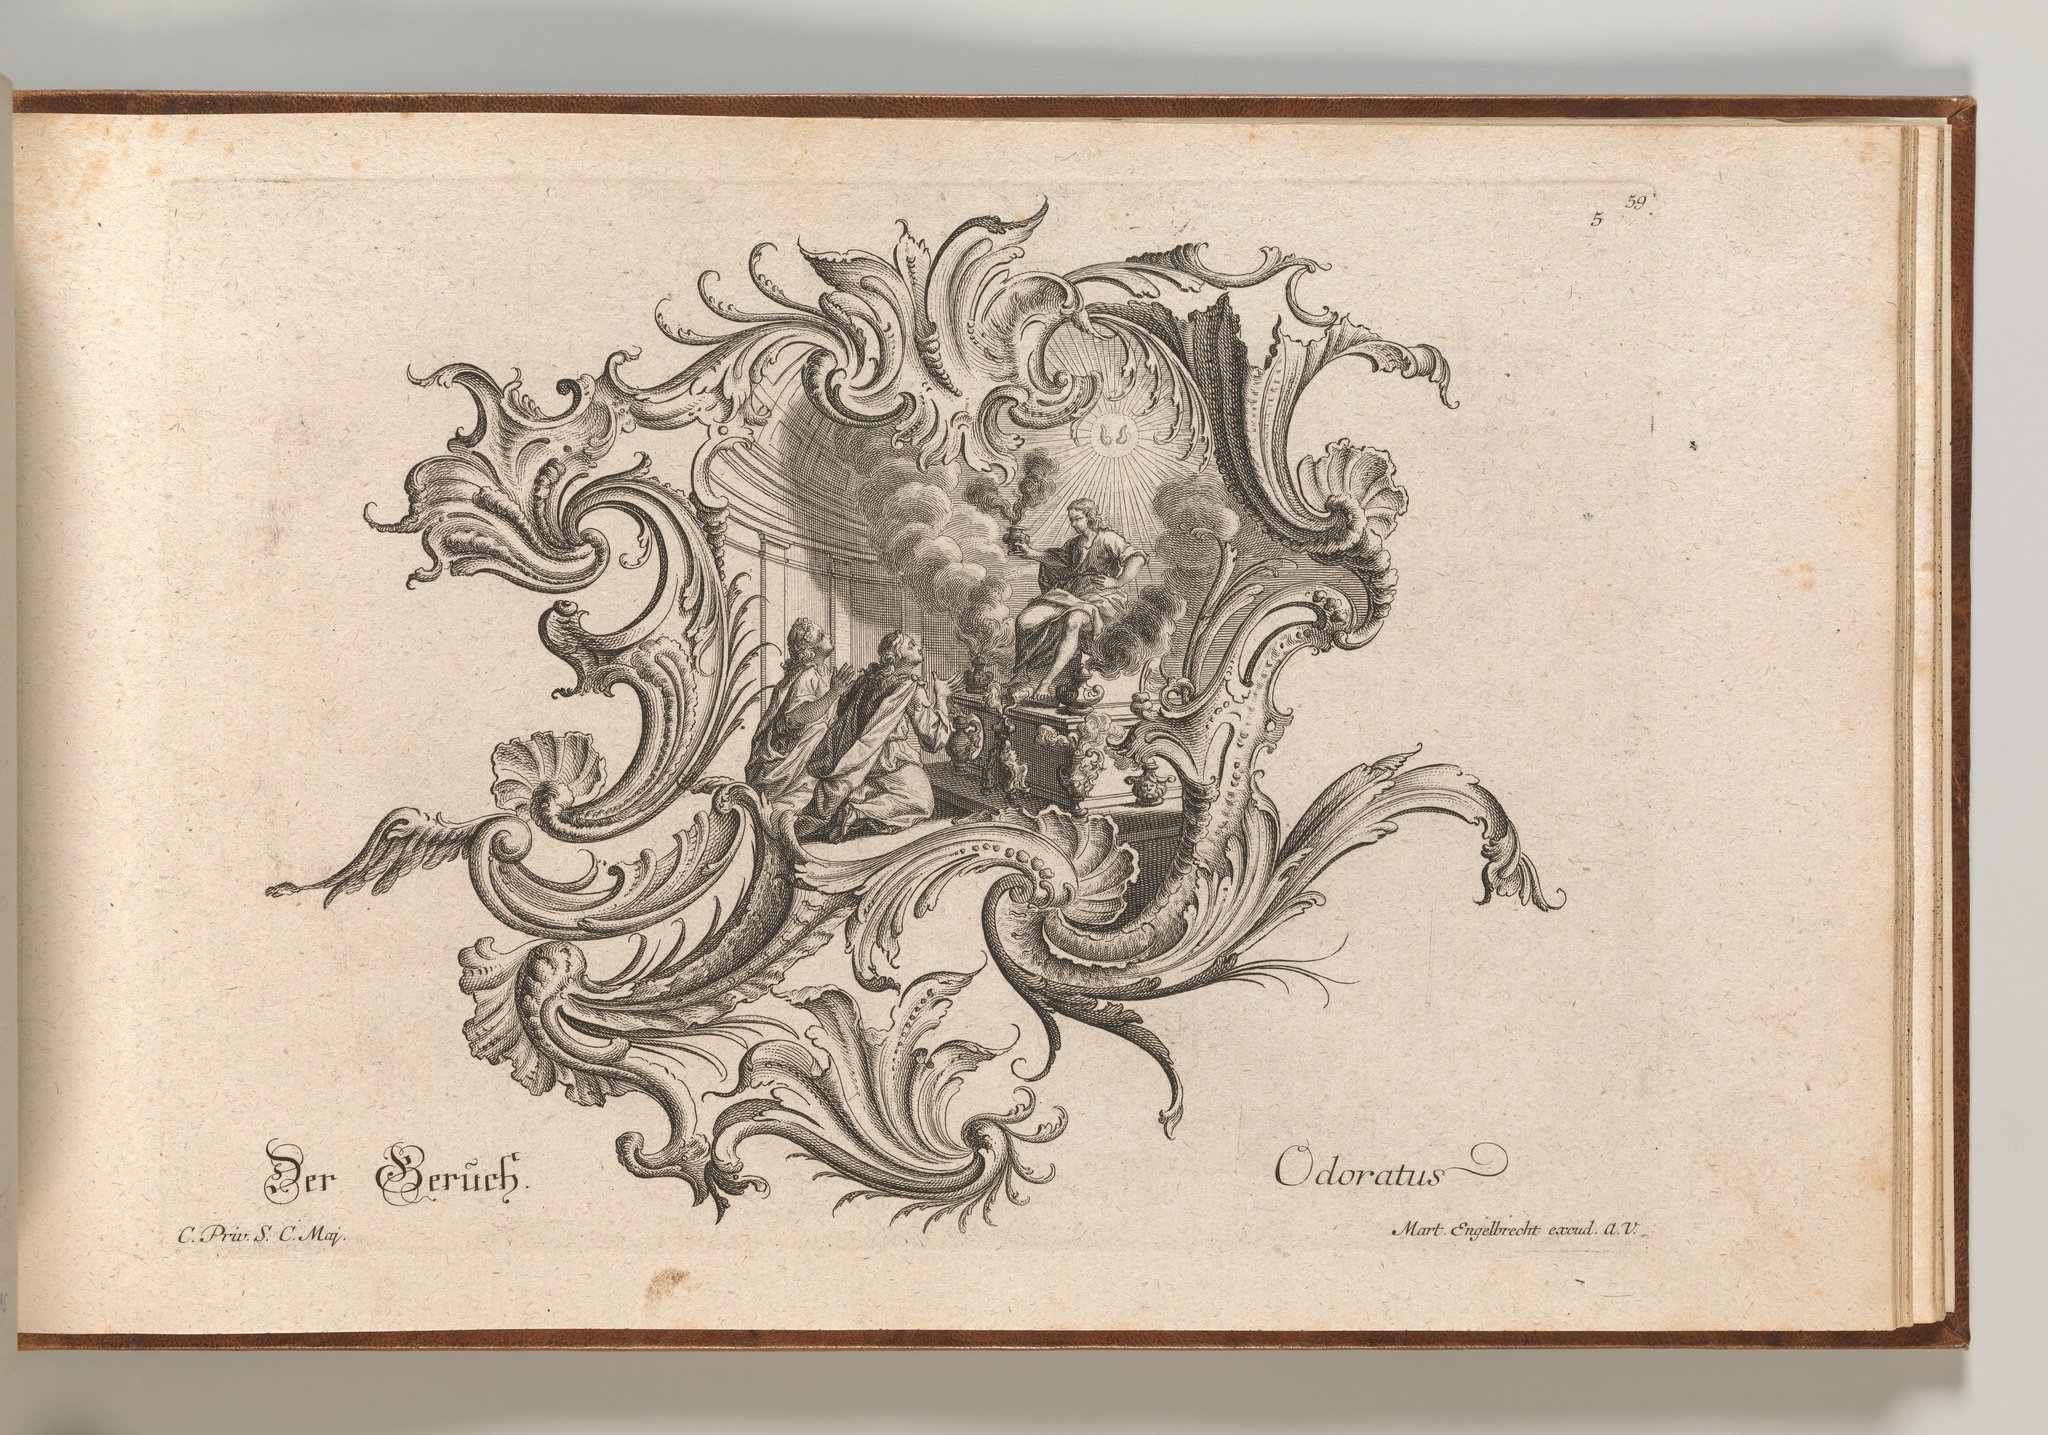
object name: album print ornament architecture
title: Design for a Cartouche and Representation of 'Smell', Plate 5 from 'Neu Inventierte auf die artigste Facon Sehr nutzliche Schild.'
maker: johann georg pintz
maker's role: engraver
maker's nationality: central european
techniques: etching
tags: altars,cartouches,men